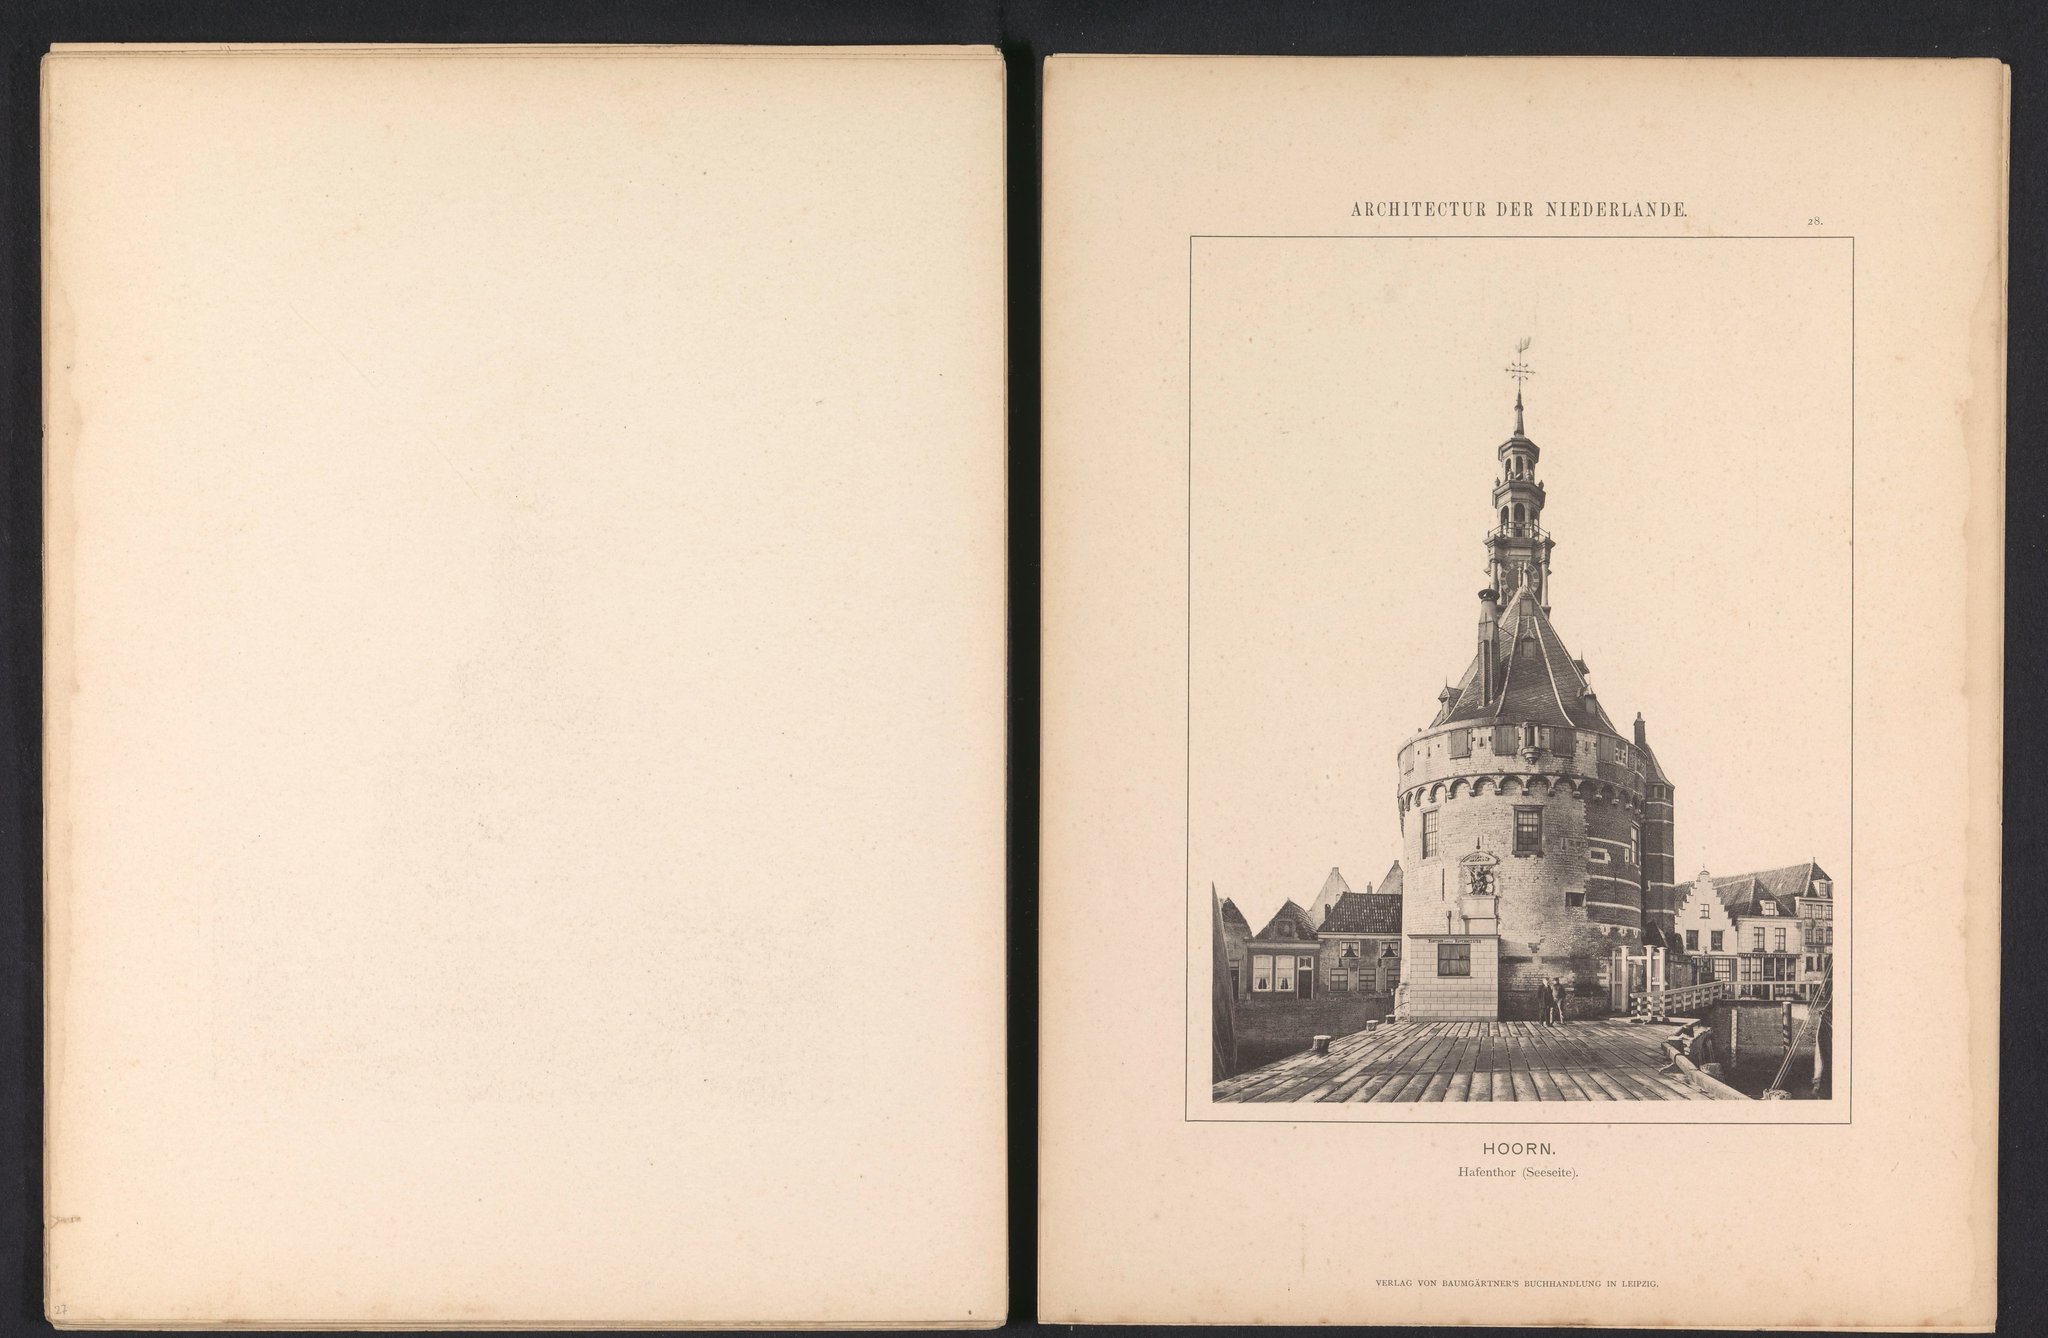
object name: photomechanical print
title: Architectur der Niederlande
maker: Anonymous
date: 1884-1894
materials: paper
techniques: photograph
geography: hoorn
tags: tower, clock tower ~ monumental adornment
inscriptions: number: ‘28.’